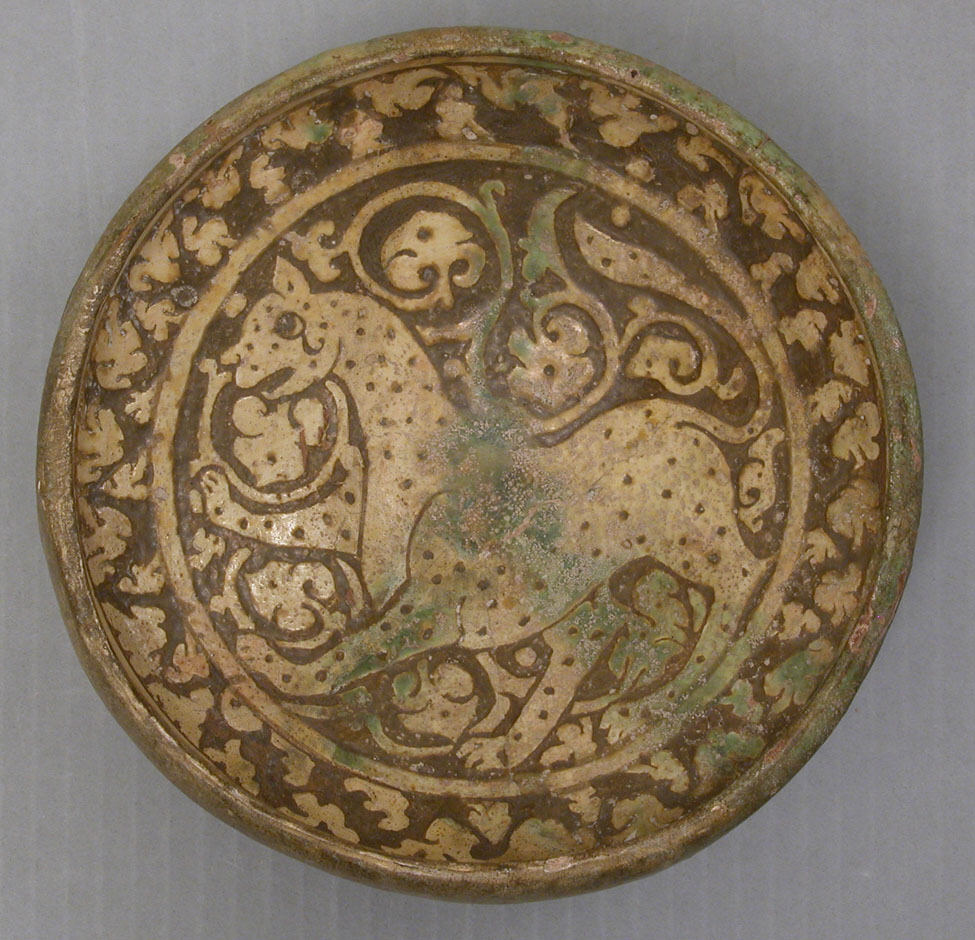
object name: bowl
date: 1001-1200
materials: earthenware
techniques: glazing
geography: iran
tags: animals